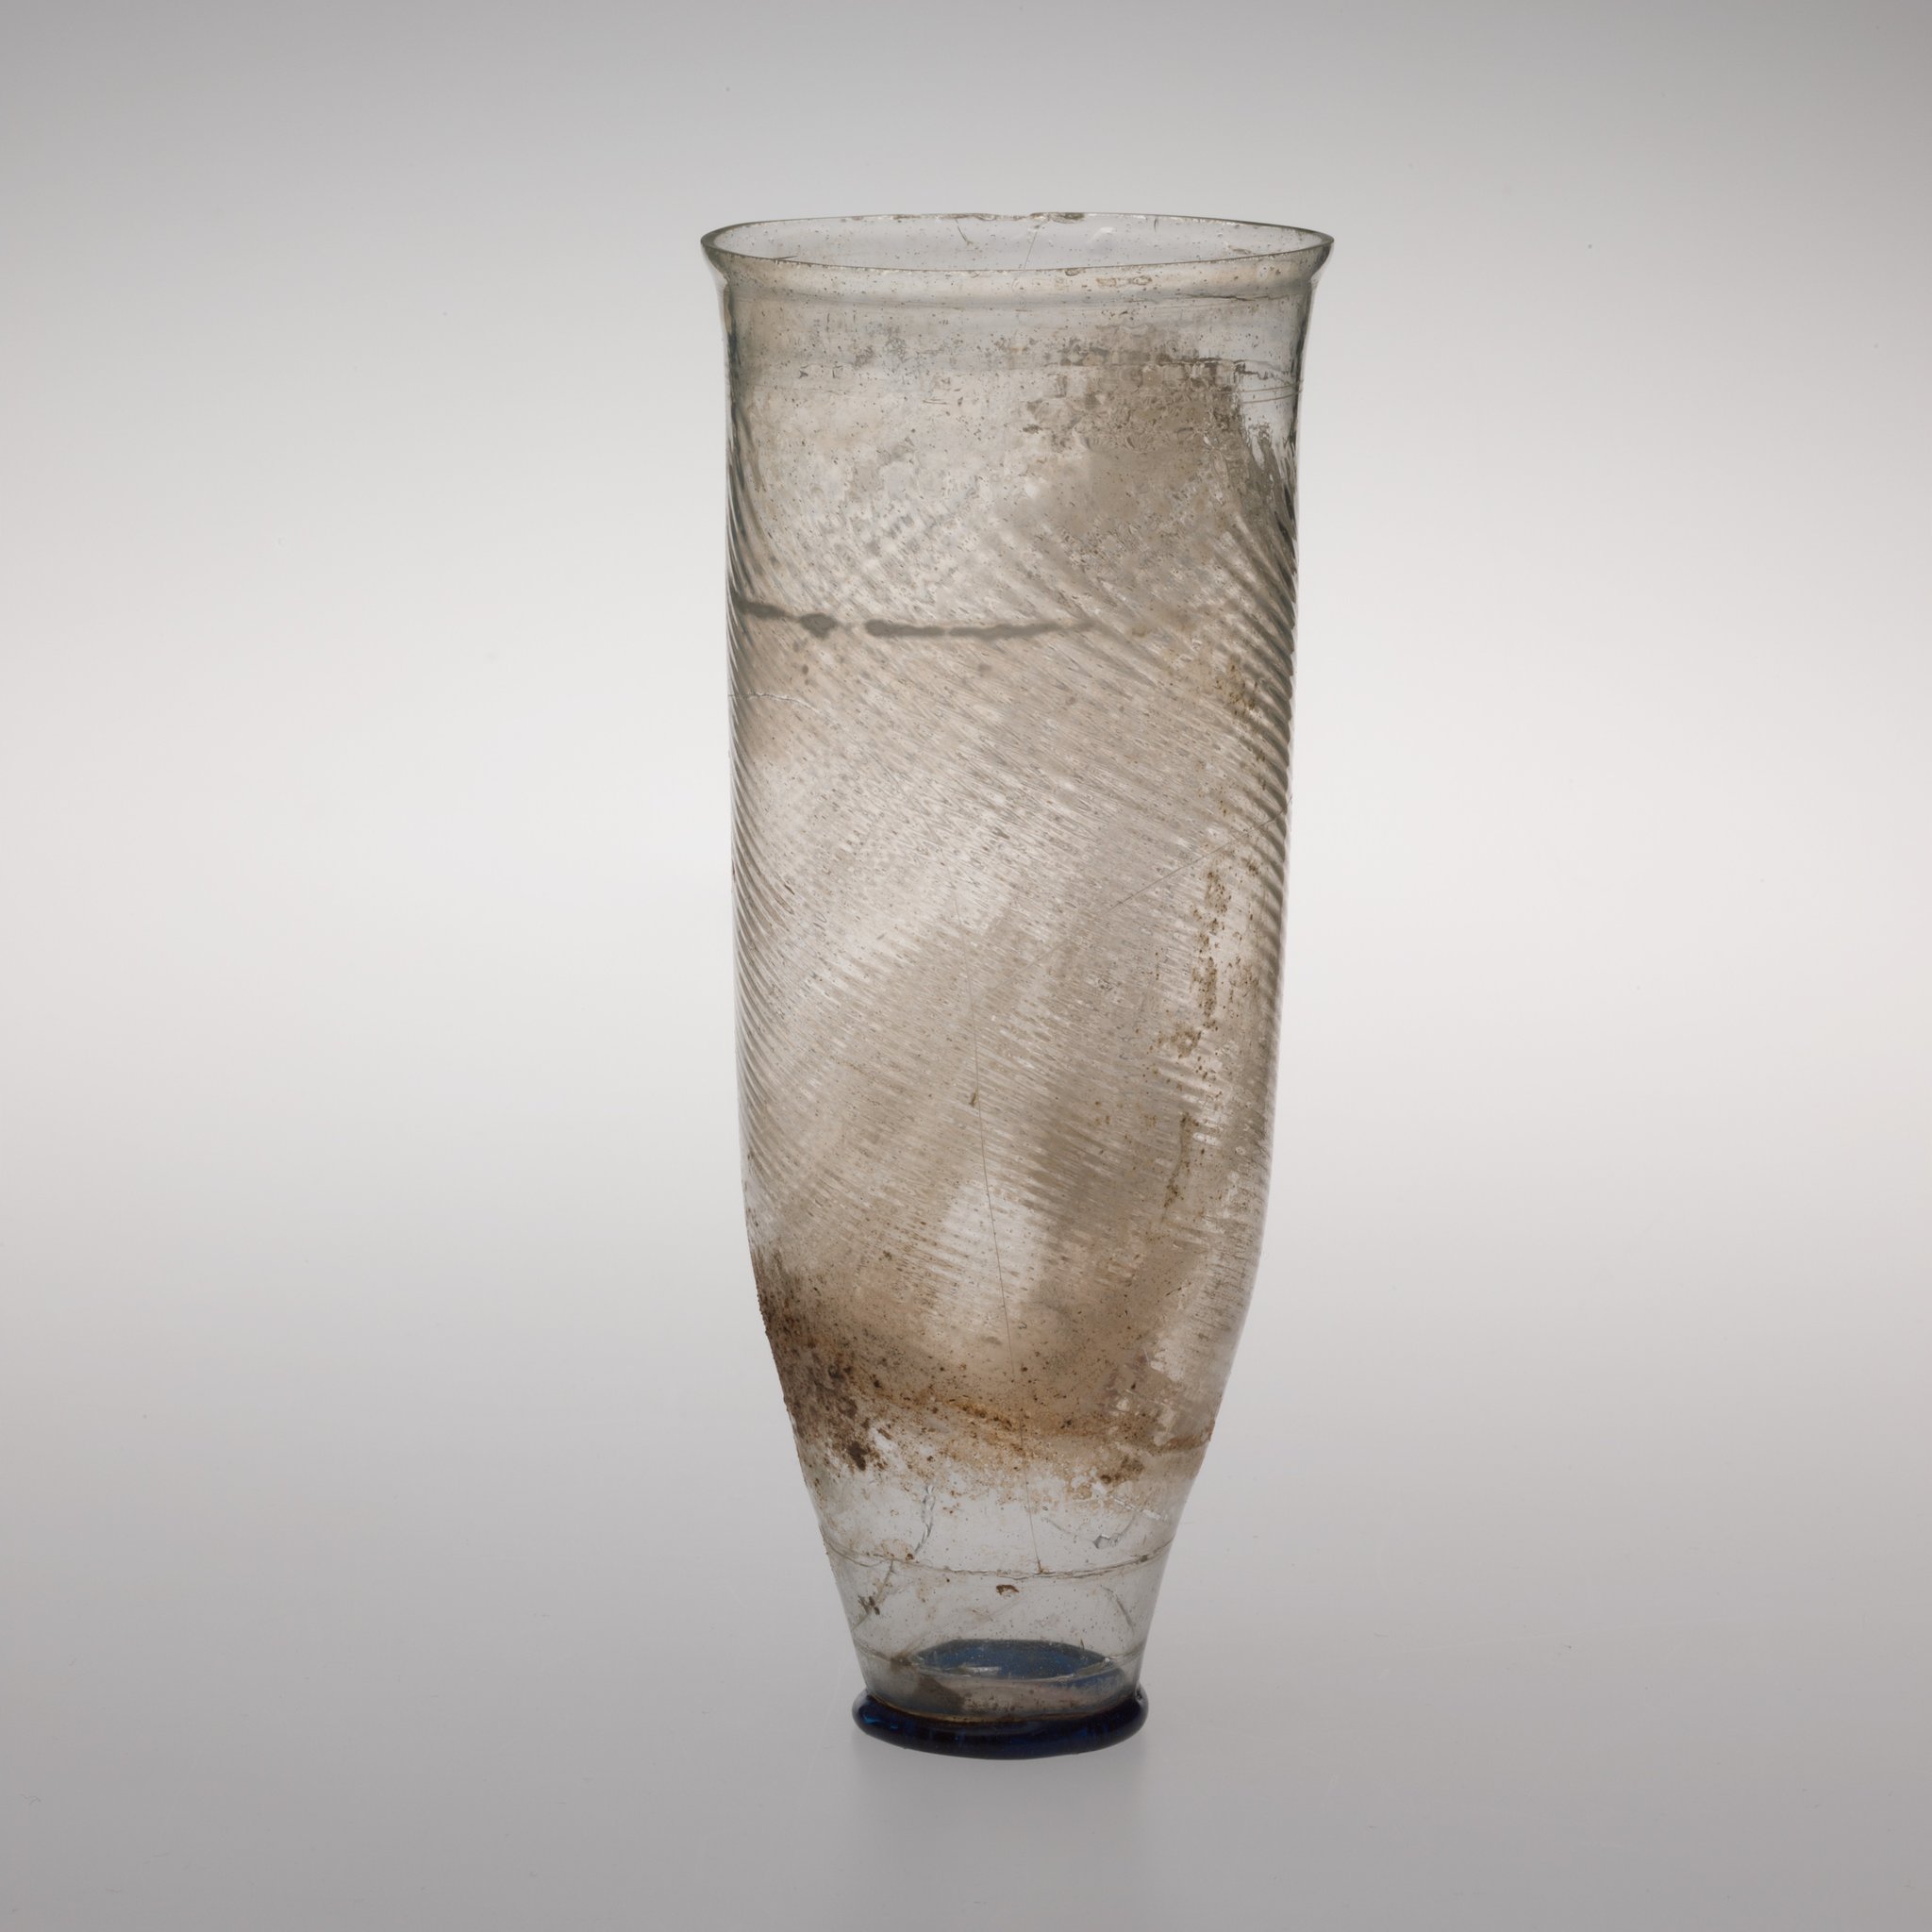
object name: beaker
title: Glass beaker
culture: roman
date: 301-400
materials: glass